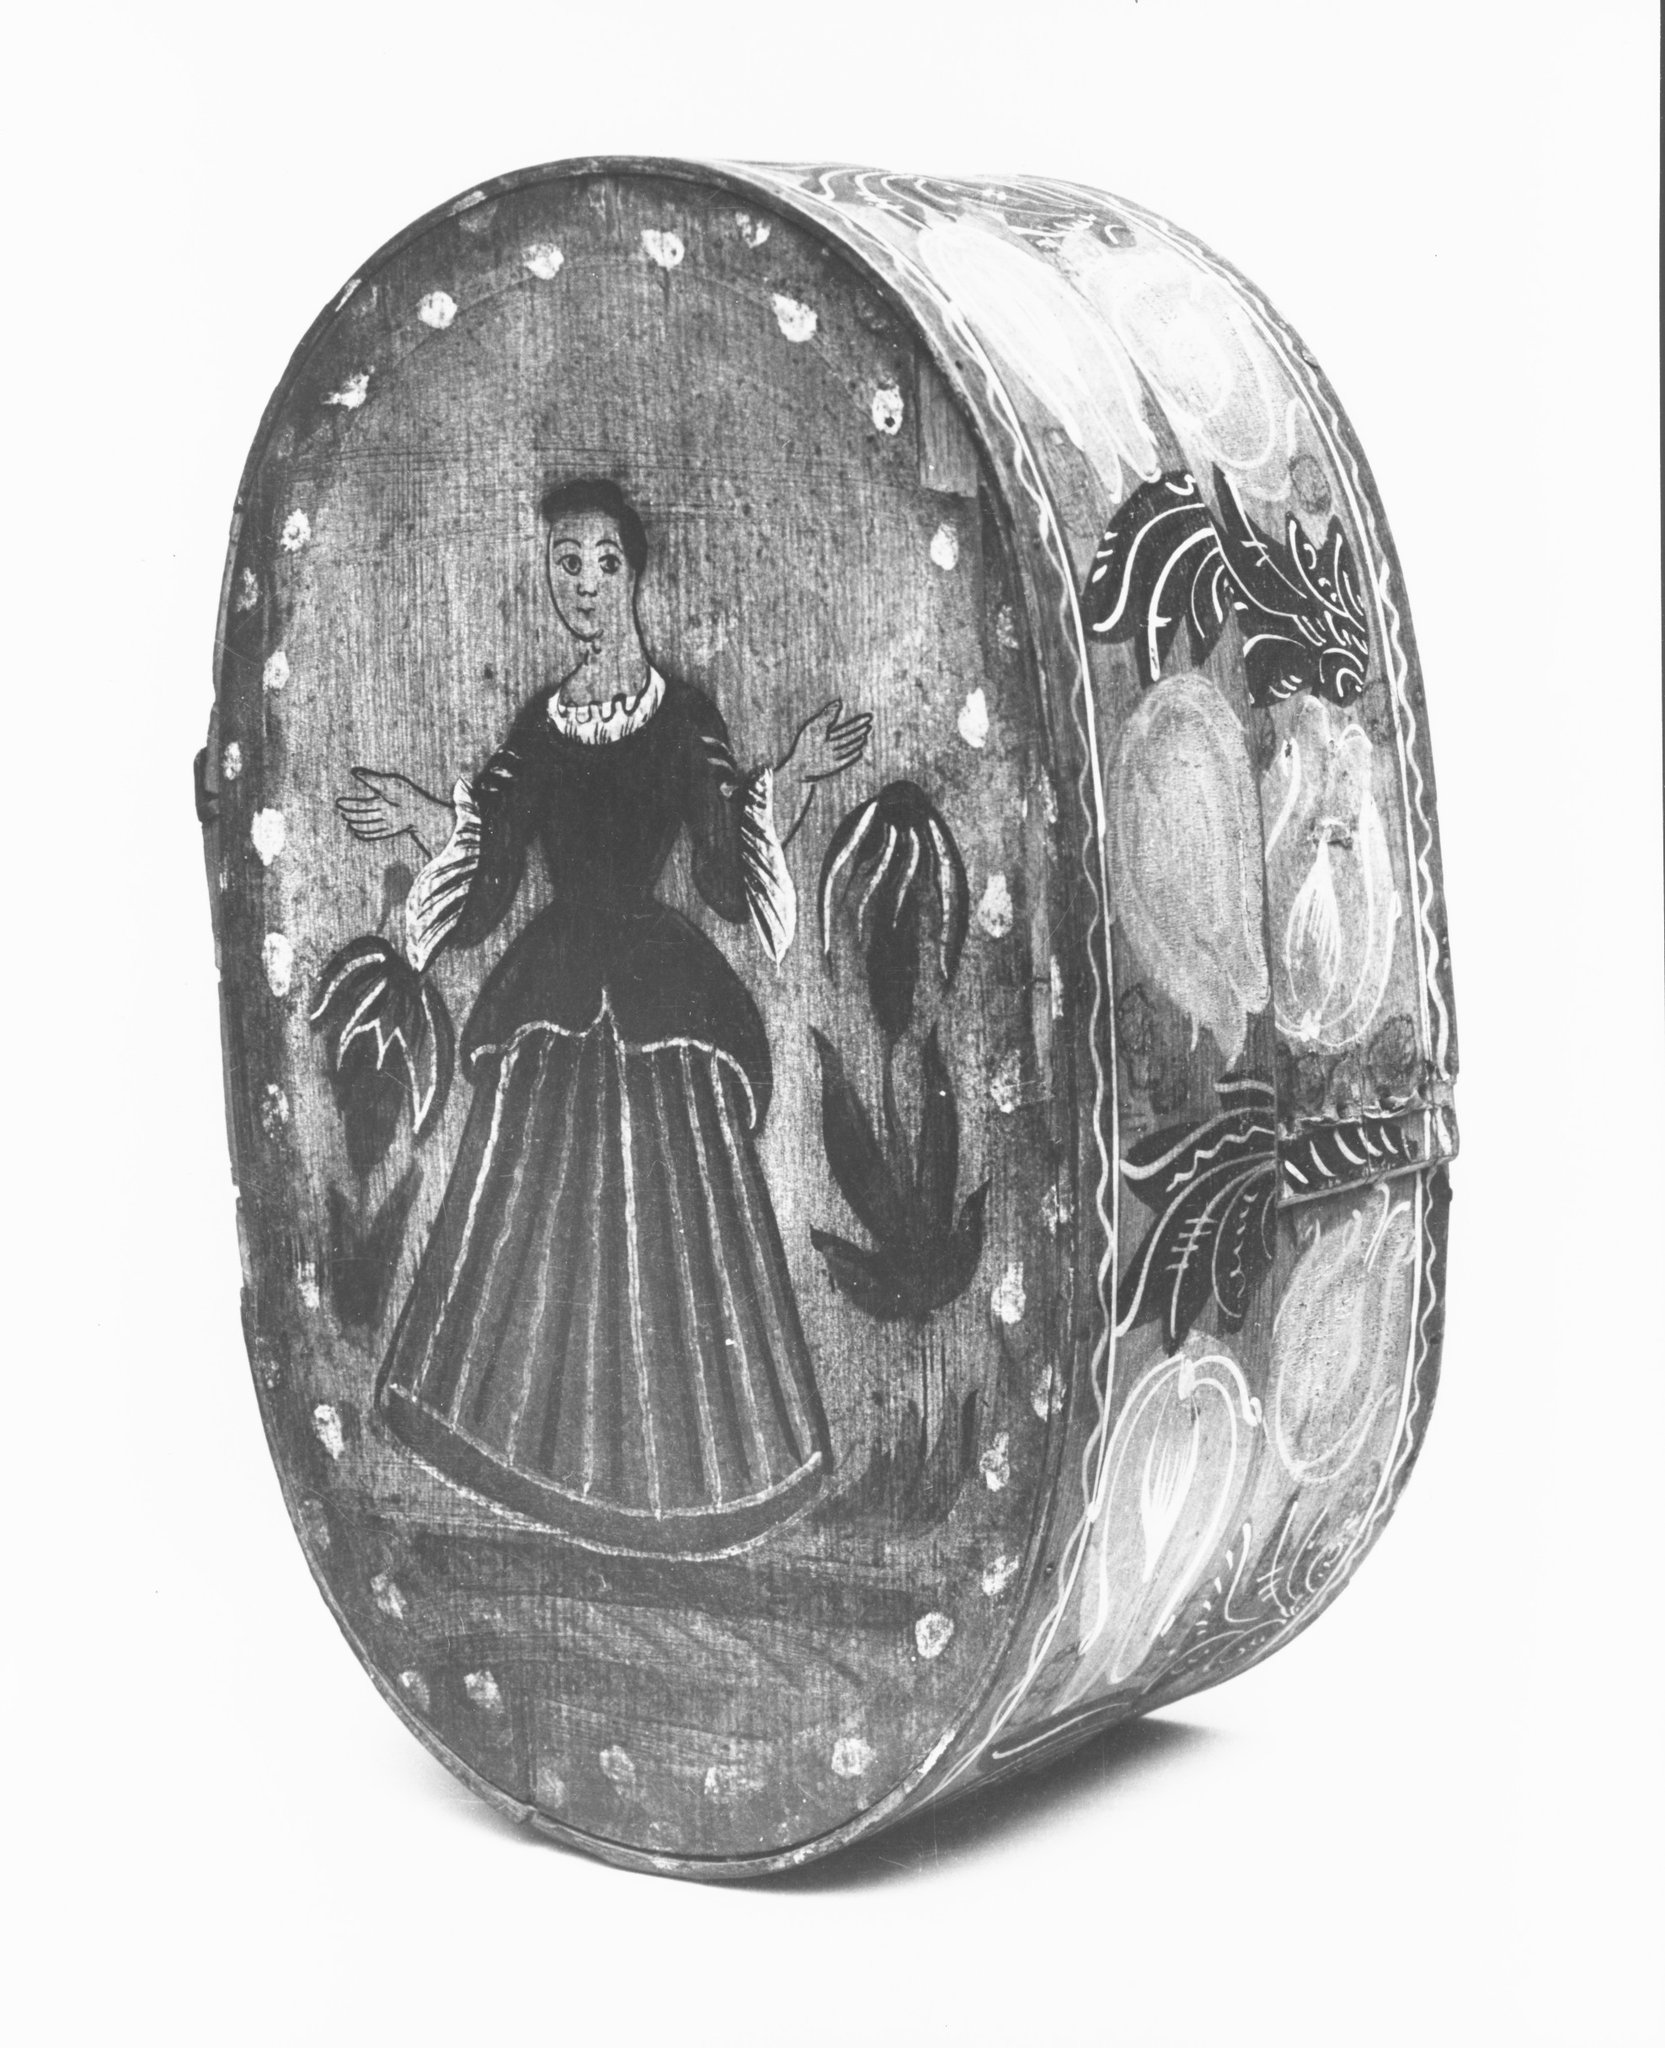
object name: bride box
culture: european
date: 1700-1800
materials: wood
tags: women,flowers